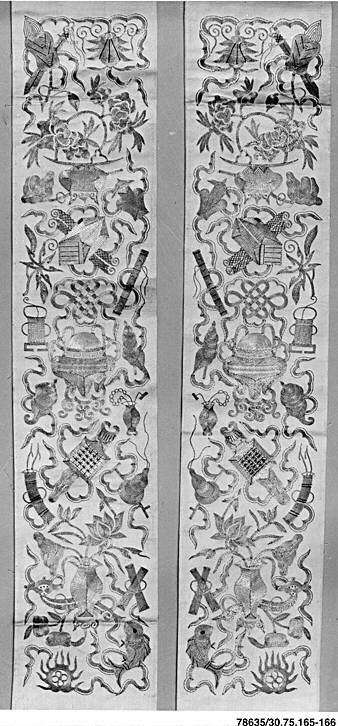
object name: sleeve band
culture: chinese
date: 1801-1900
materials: metal thread, silk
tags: flowers